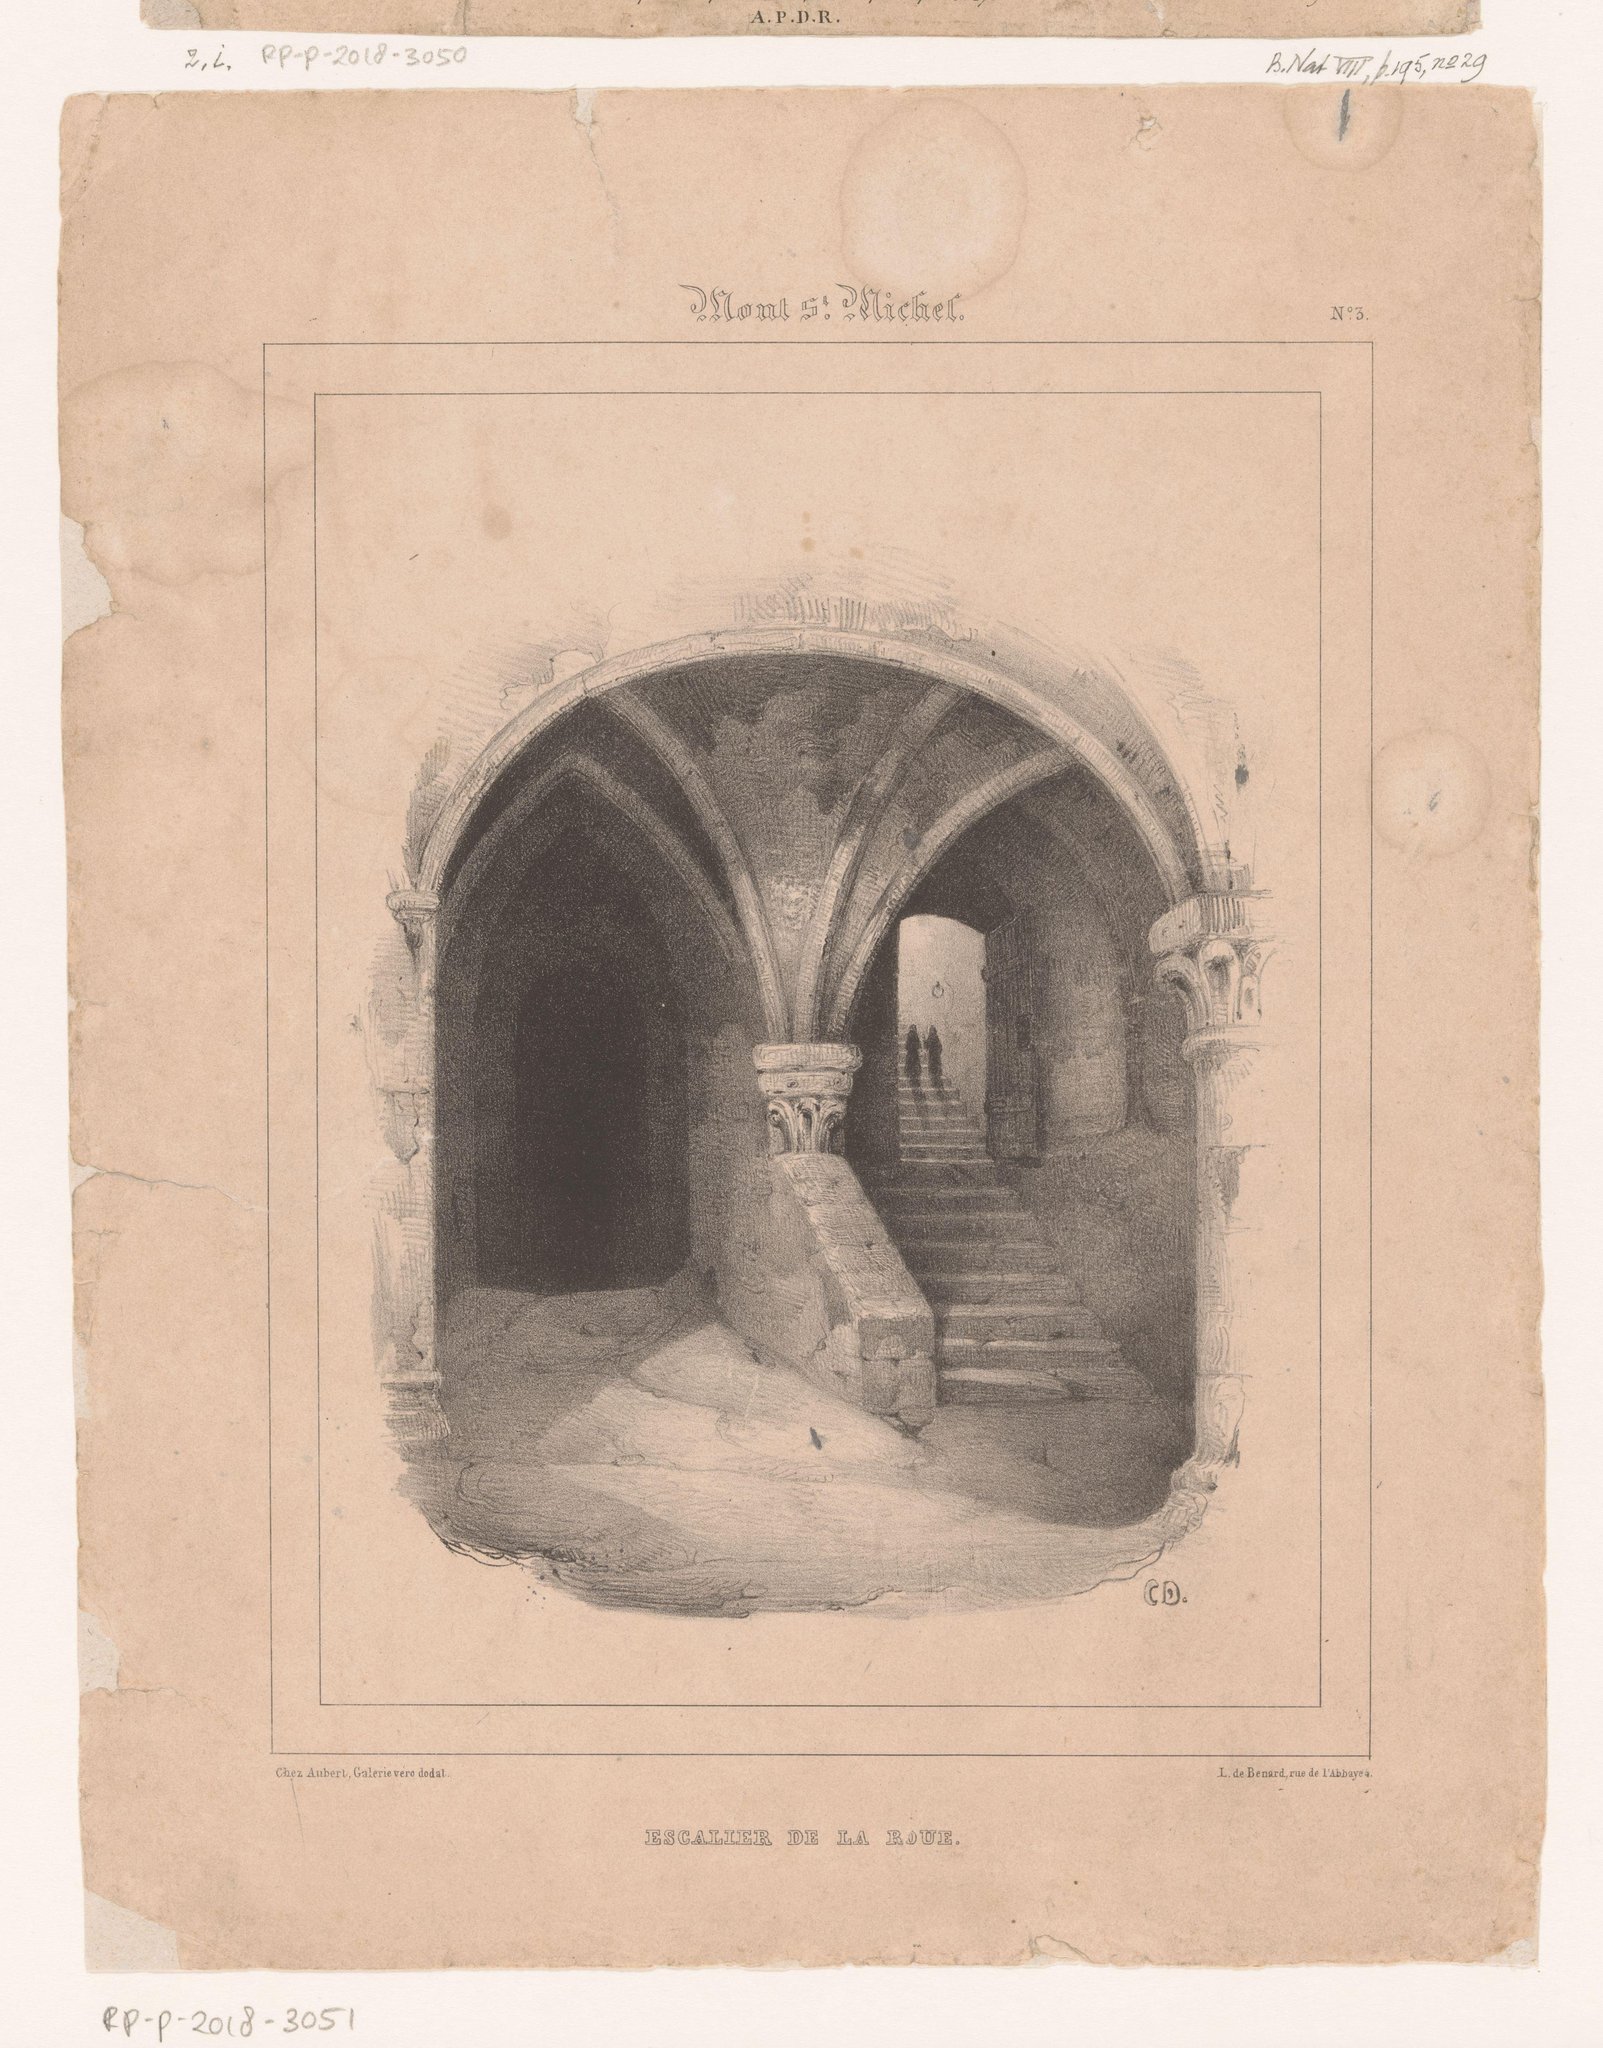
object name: print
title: Mont St. Michel. Escalier de la Roue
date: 1836-1847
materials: paper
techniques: lithograph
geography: paris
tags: island, abbey, monastery, convent ~ roman catholic church, staircase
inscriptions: collector's mark: Lugt 2228, monogram: ‘CD.’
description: Prent maakt mogelijk deel uit van een serie.